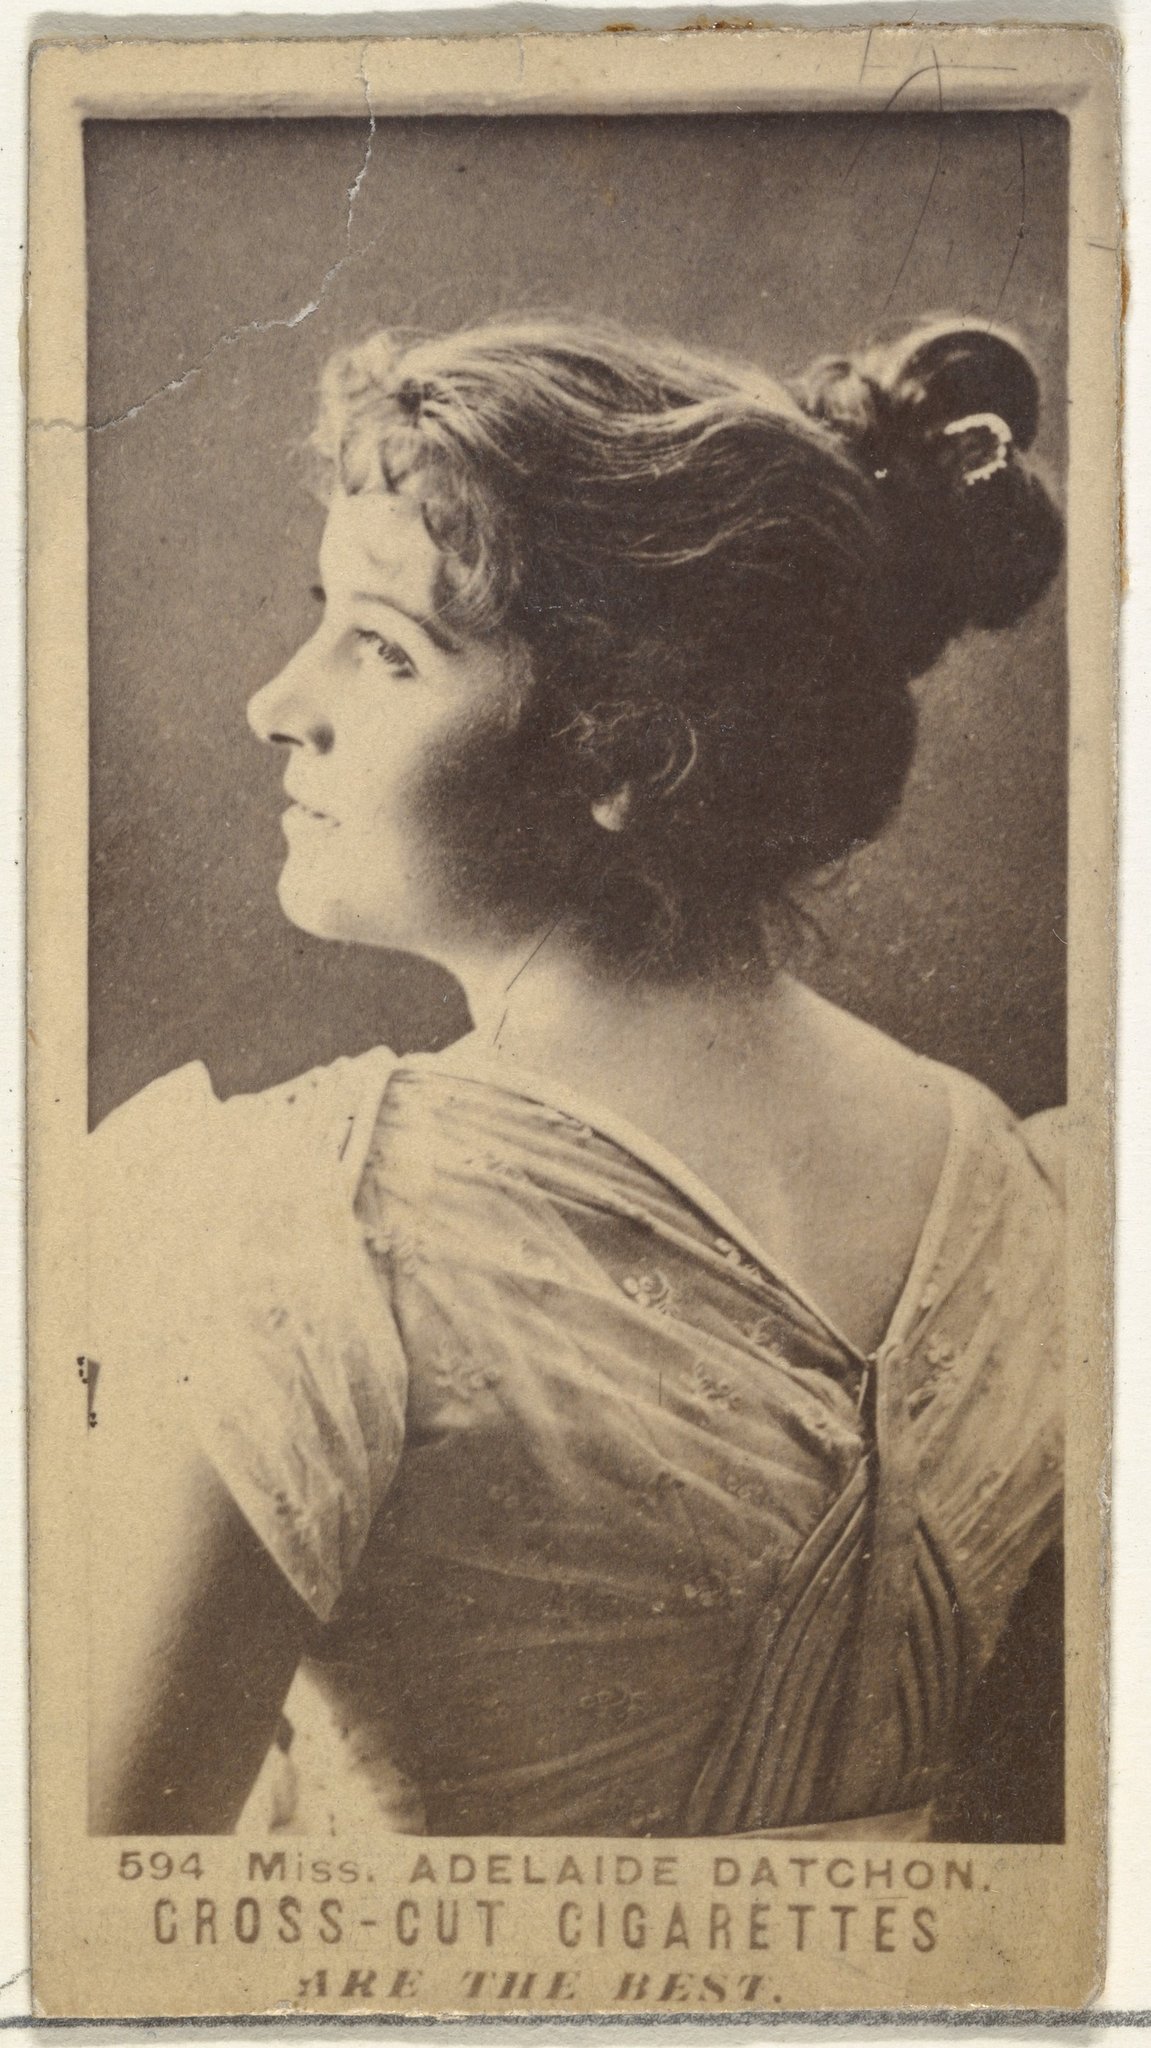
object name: photograph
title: Card Number 594, Miss Adelaide Datchon, from the Actors and Actresses series (N145-3) issued by Duke Sons & Co. to promote Cross Cut Cigarettes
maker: w. duke, sons & co.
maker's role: publisher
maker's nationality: american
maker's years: 1870-1920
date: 1880-1889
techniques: albumen silver print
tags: women,actresses